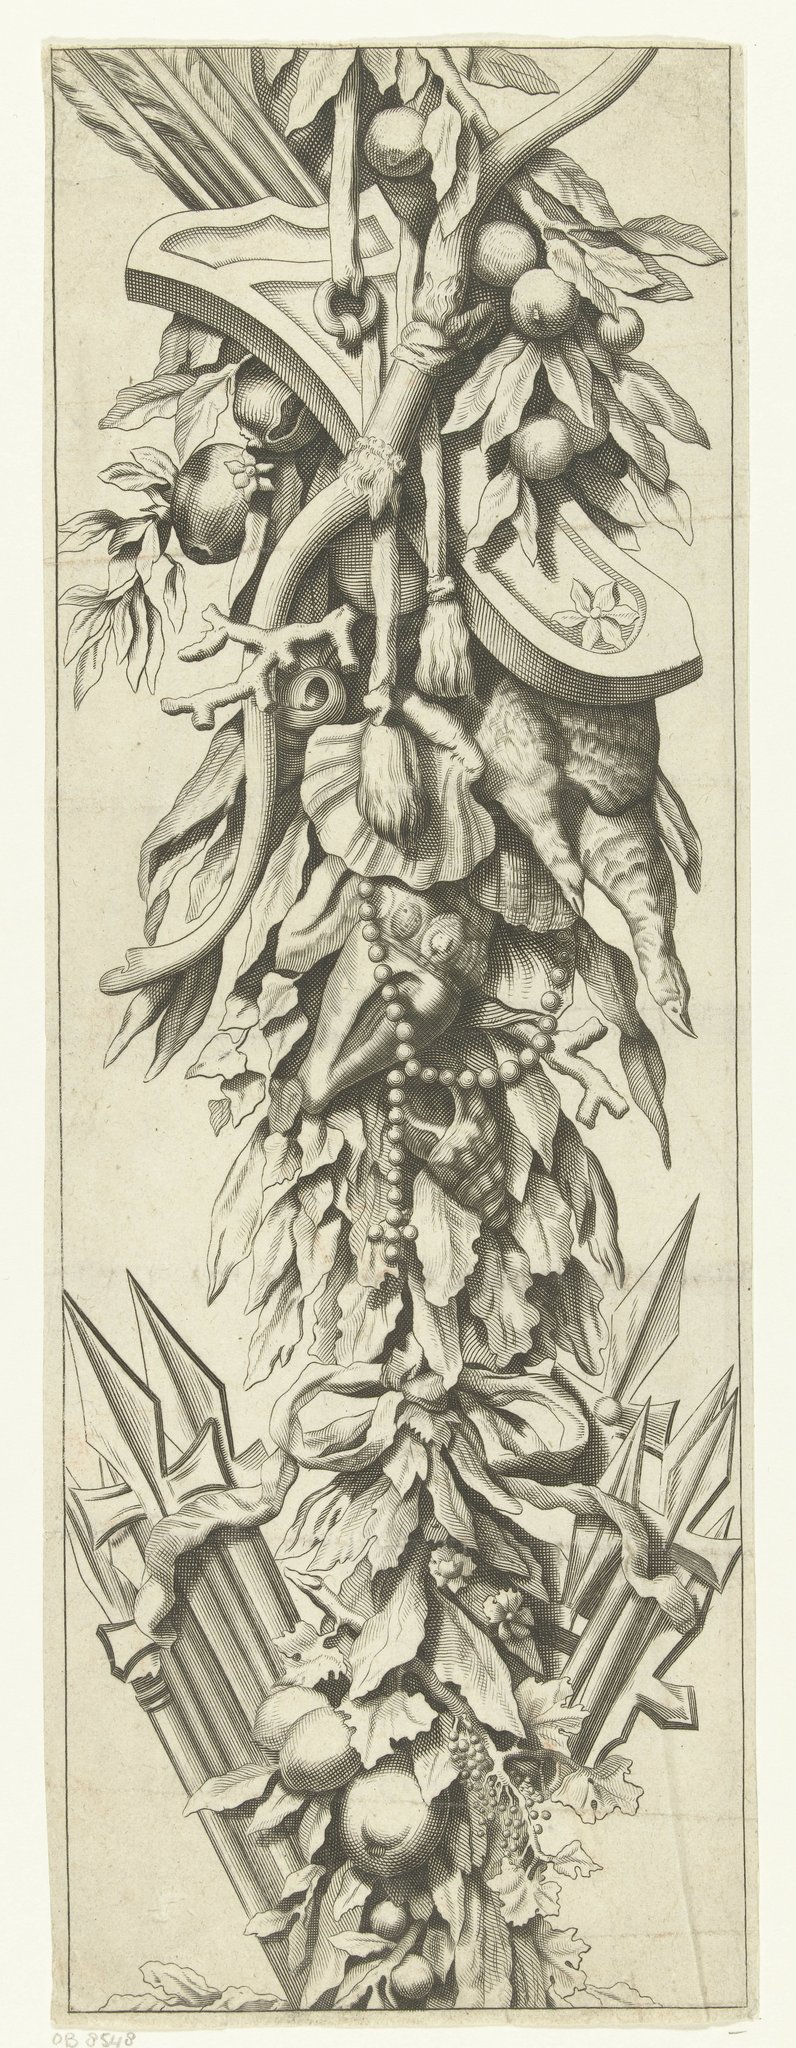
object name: ornament print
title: Trofeeën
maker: Anonymous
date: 1675-1700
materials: paper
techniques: etching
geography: amsterdam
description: Daartussen hangen schelpen, koraal, bladeren en dode vogels.